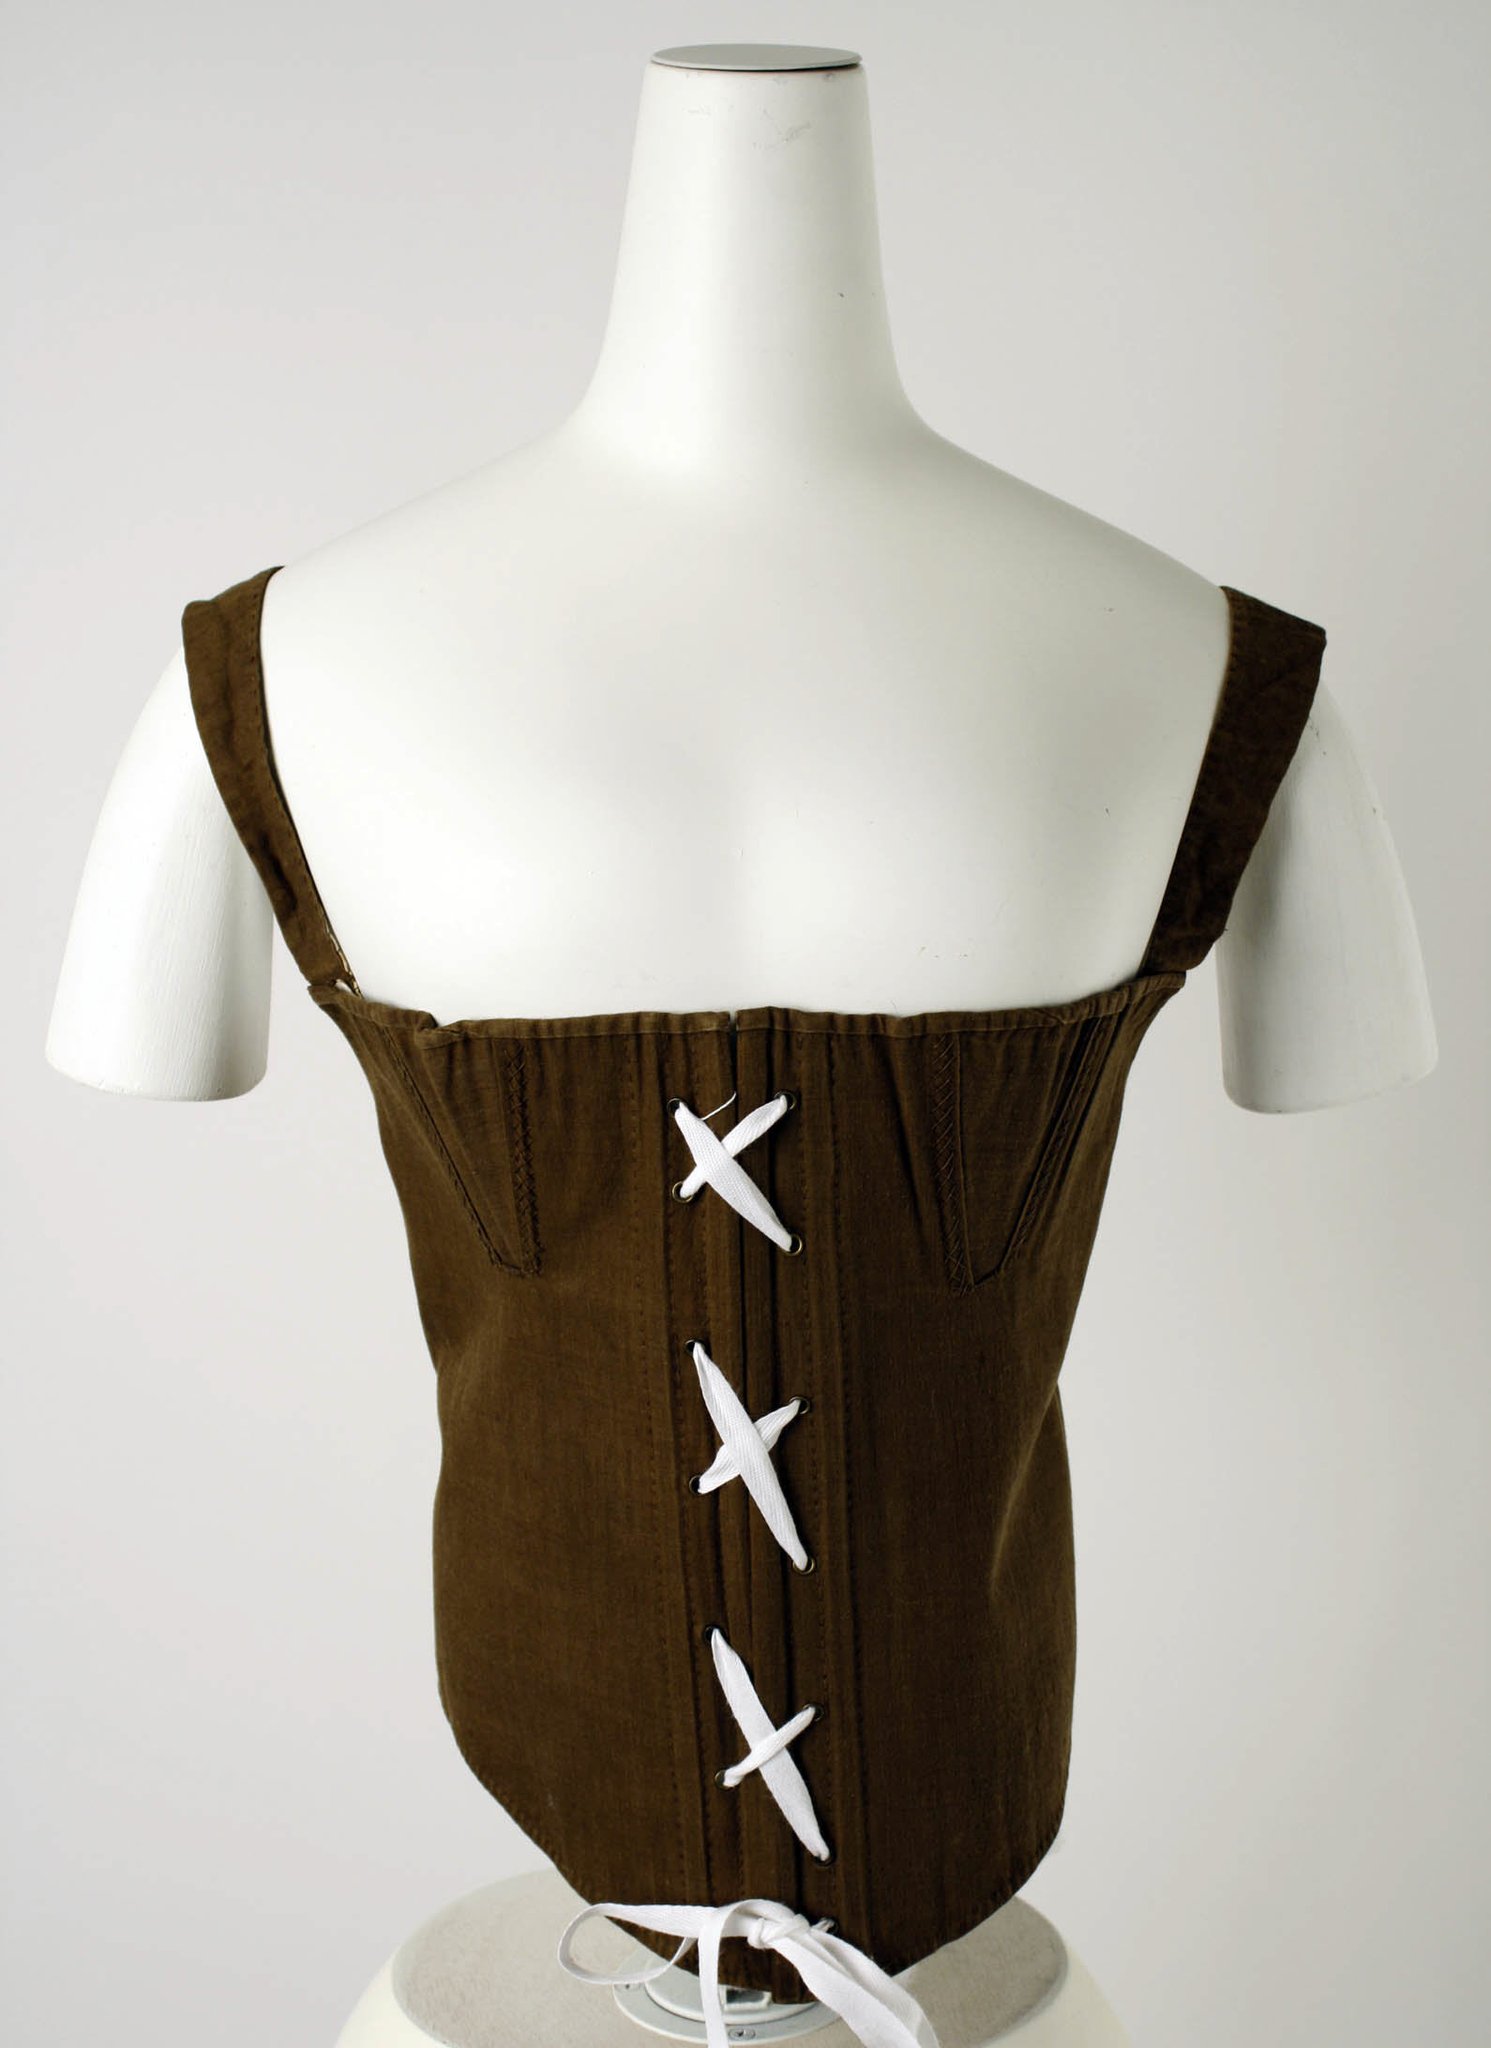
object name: corset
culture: american or european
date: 1810-1850